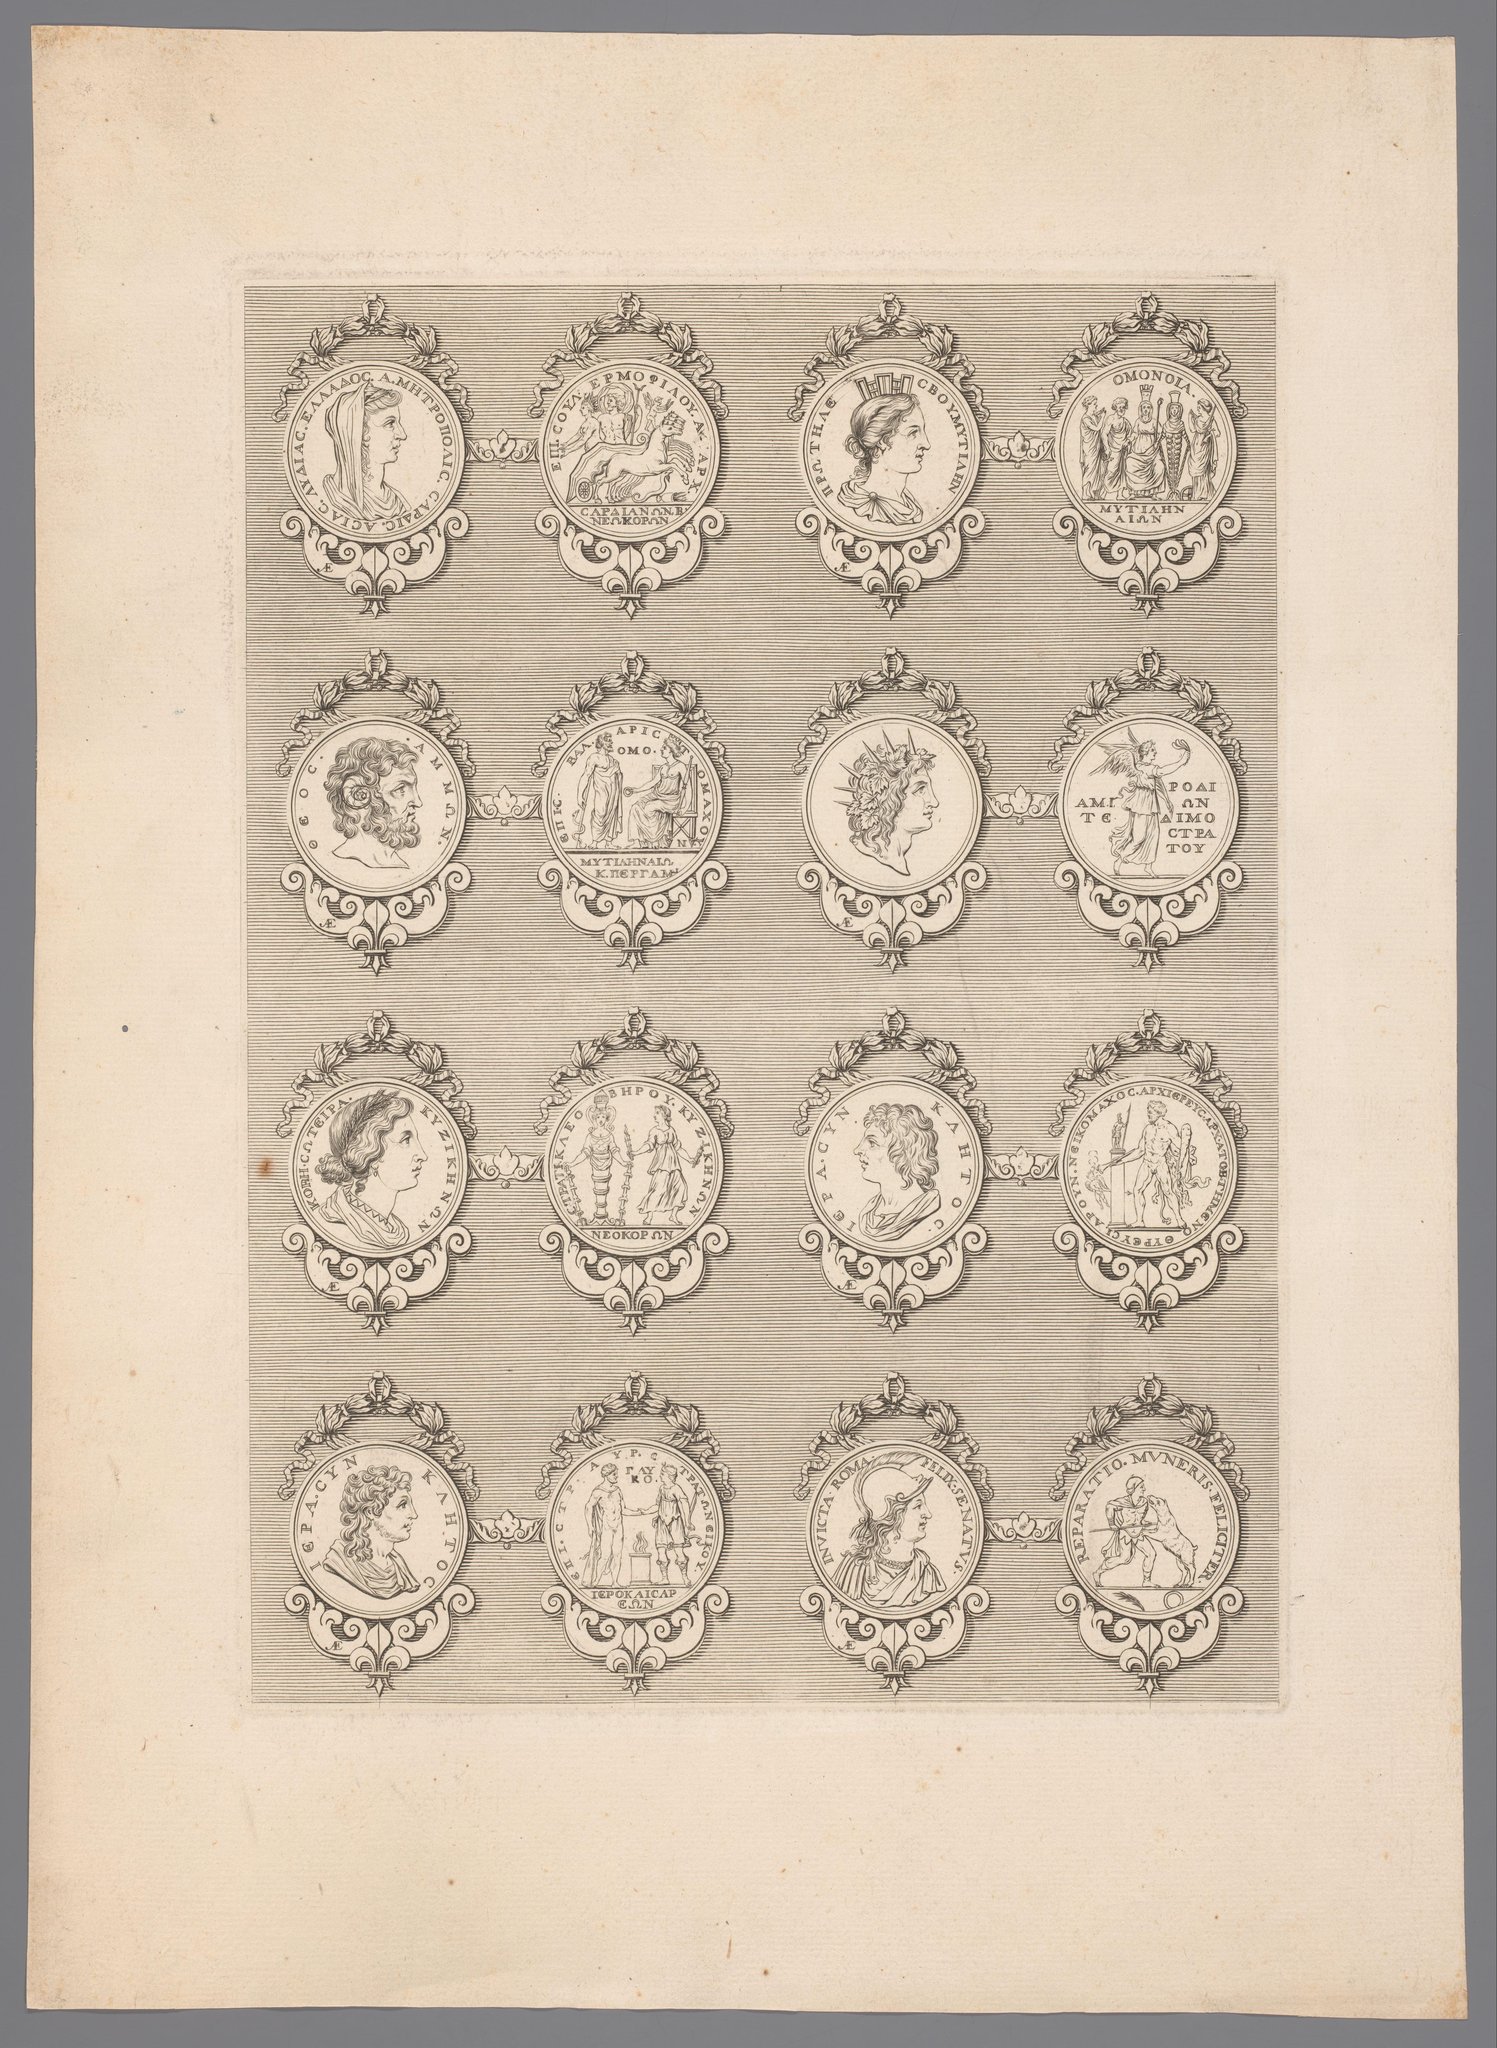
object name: print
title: Penningen in versierde lijsten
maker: simon de la boissière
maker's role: print maker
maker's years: 1637-1682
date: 1647-1682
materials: paper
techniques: etching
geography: france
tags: medal (considered as a piece of sculpture, regardless of its specific function)